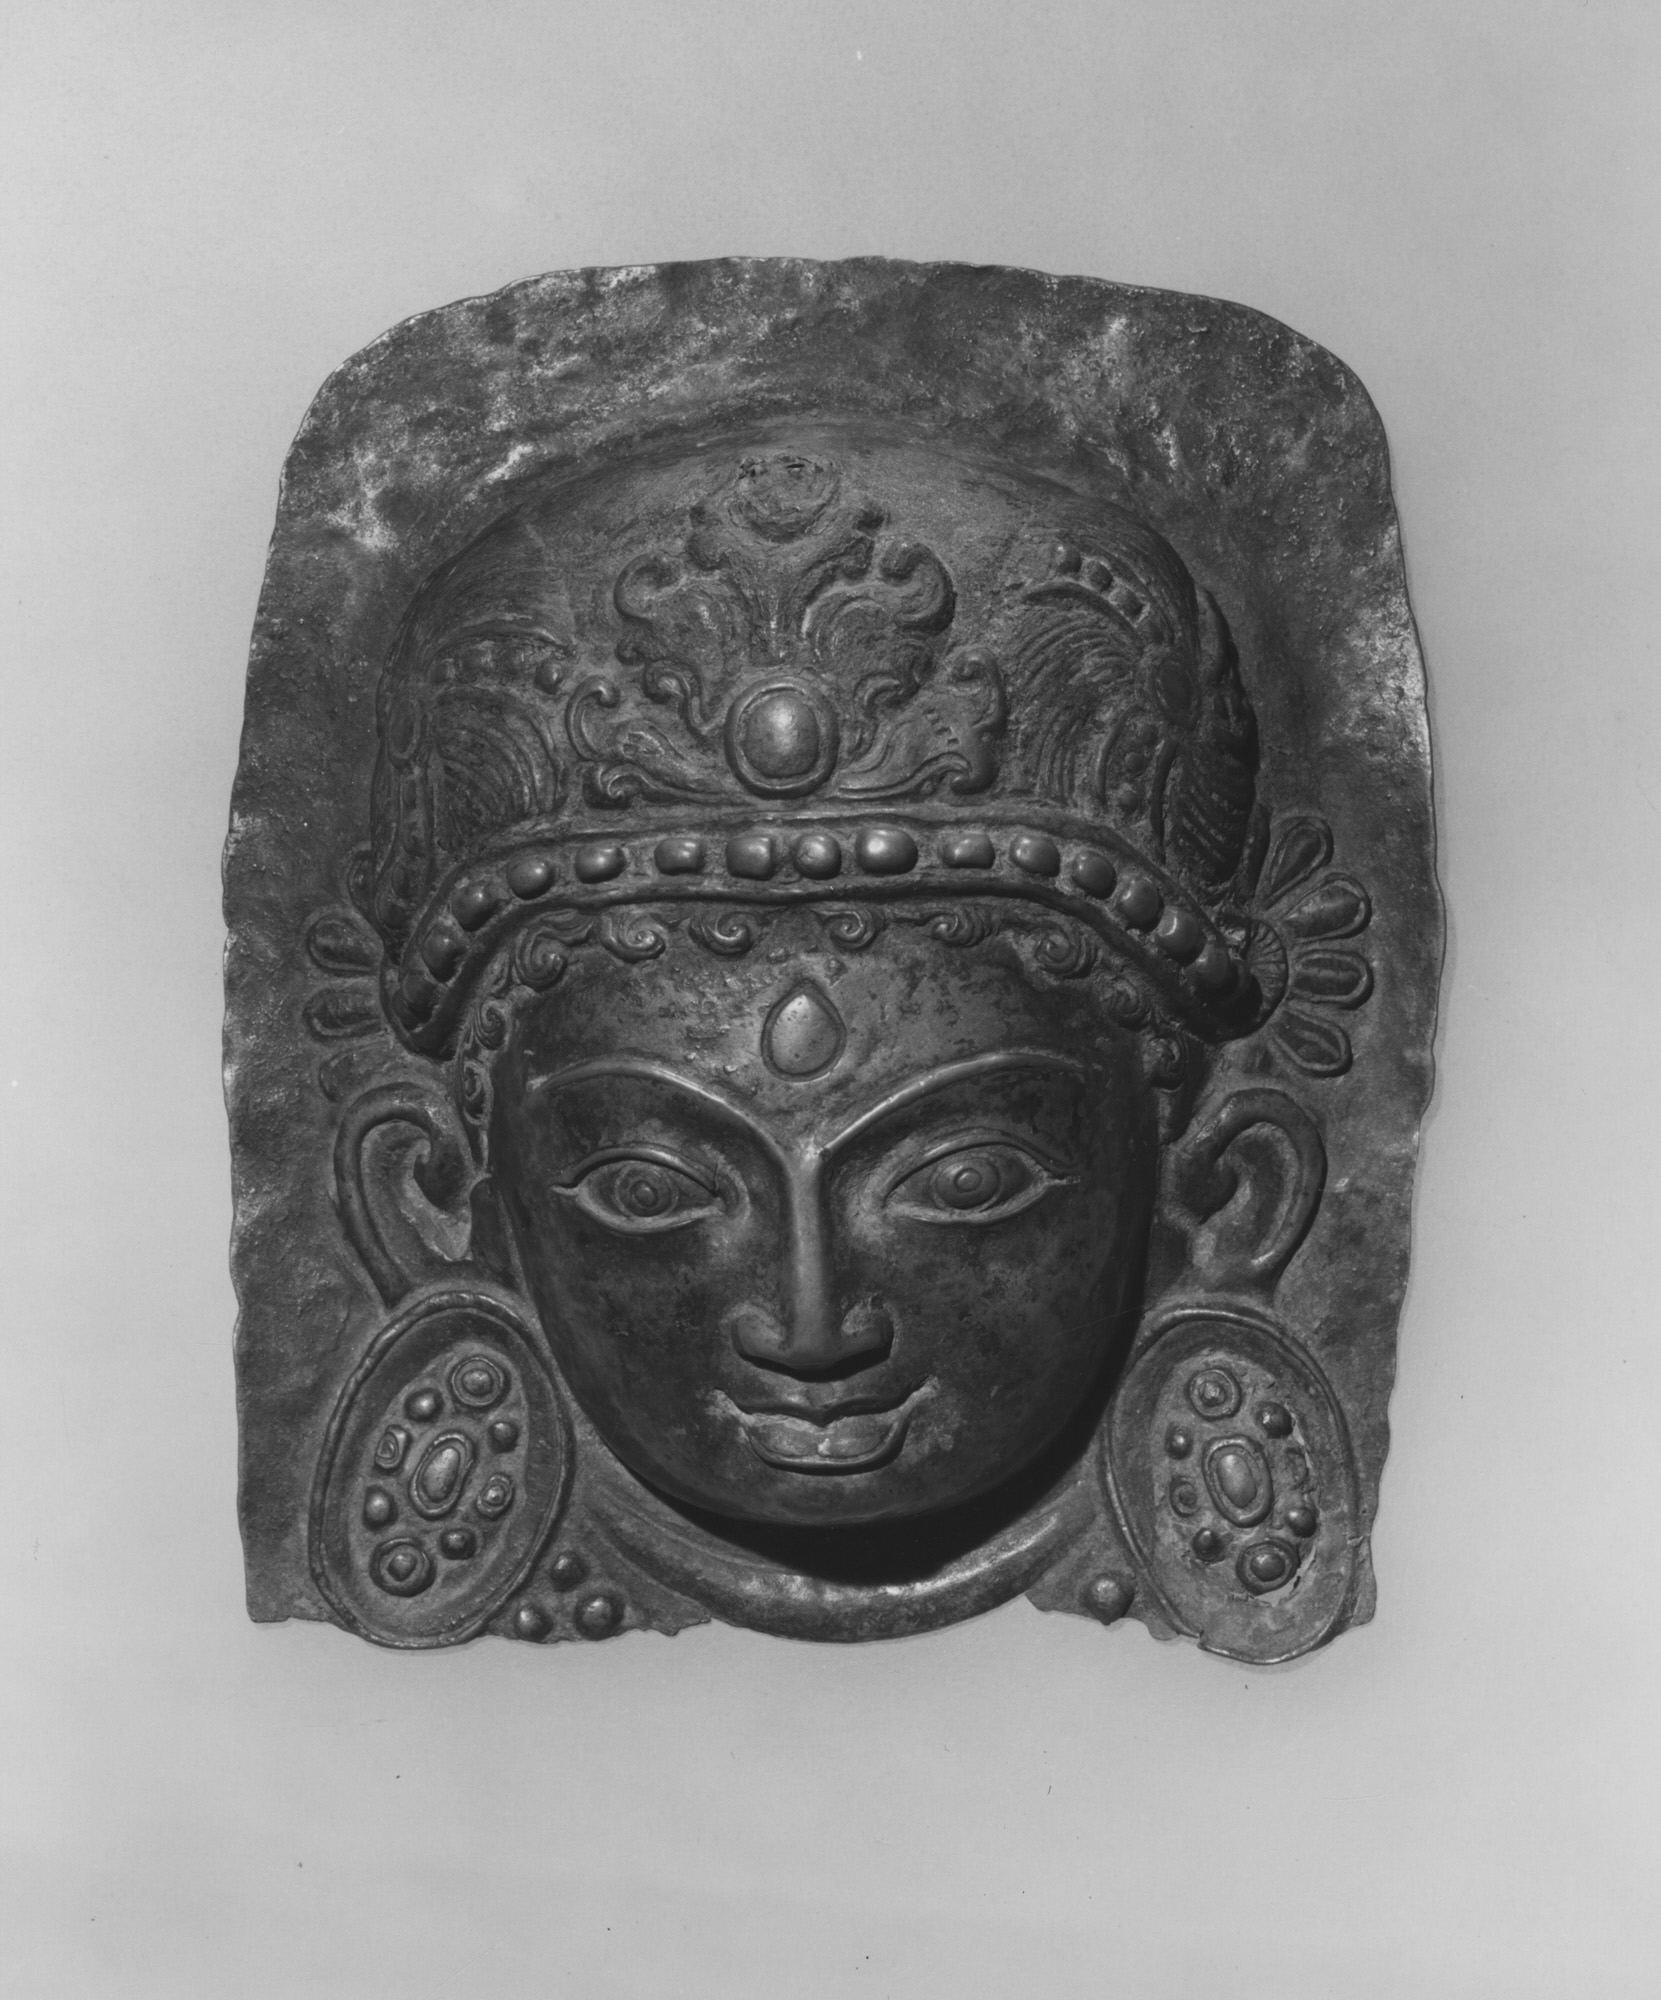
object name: relief plaque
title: Relief Plaque of Hindu Deity, Probably Processional: Face of a Deity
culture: nepali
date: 1301-1600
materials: copper alloy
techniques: repoussé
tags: faces,hinduism